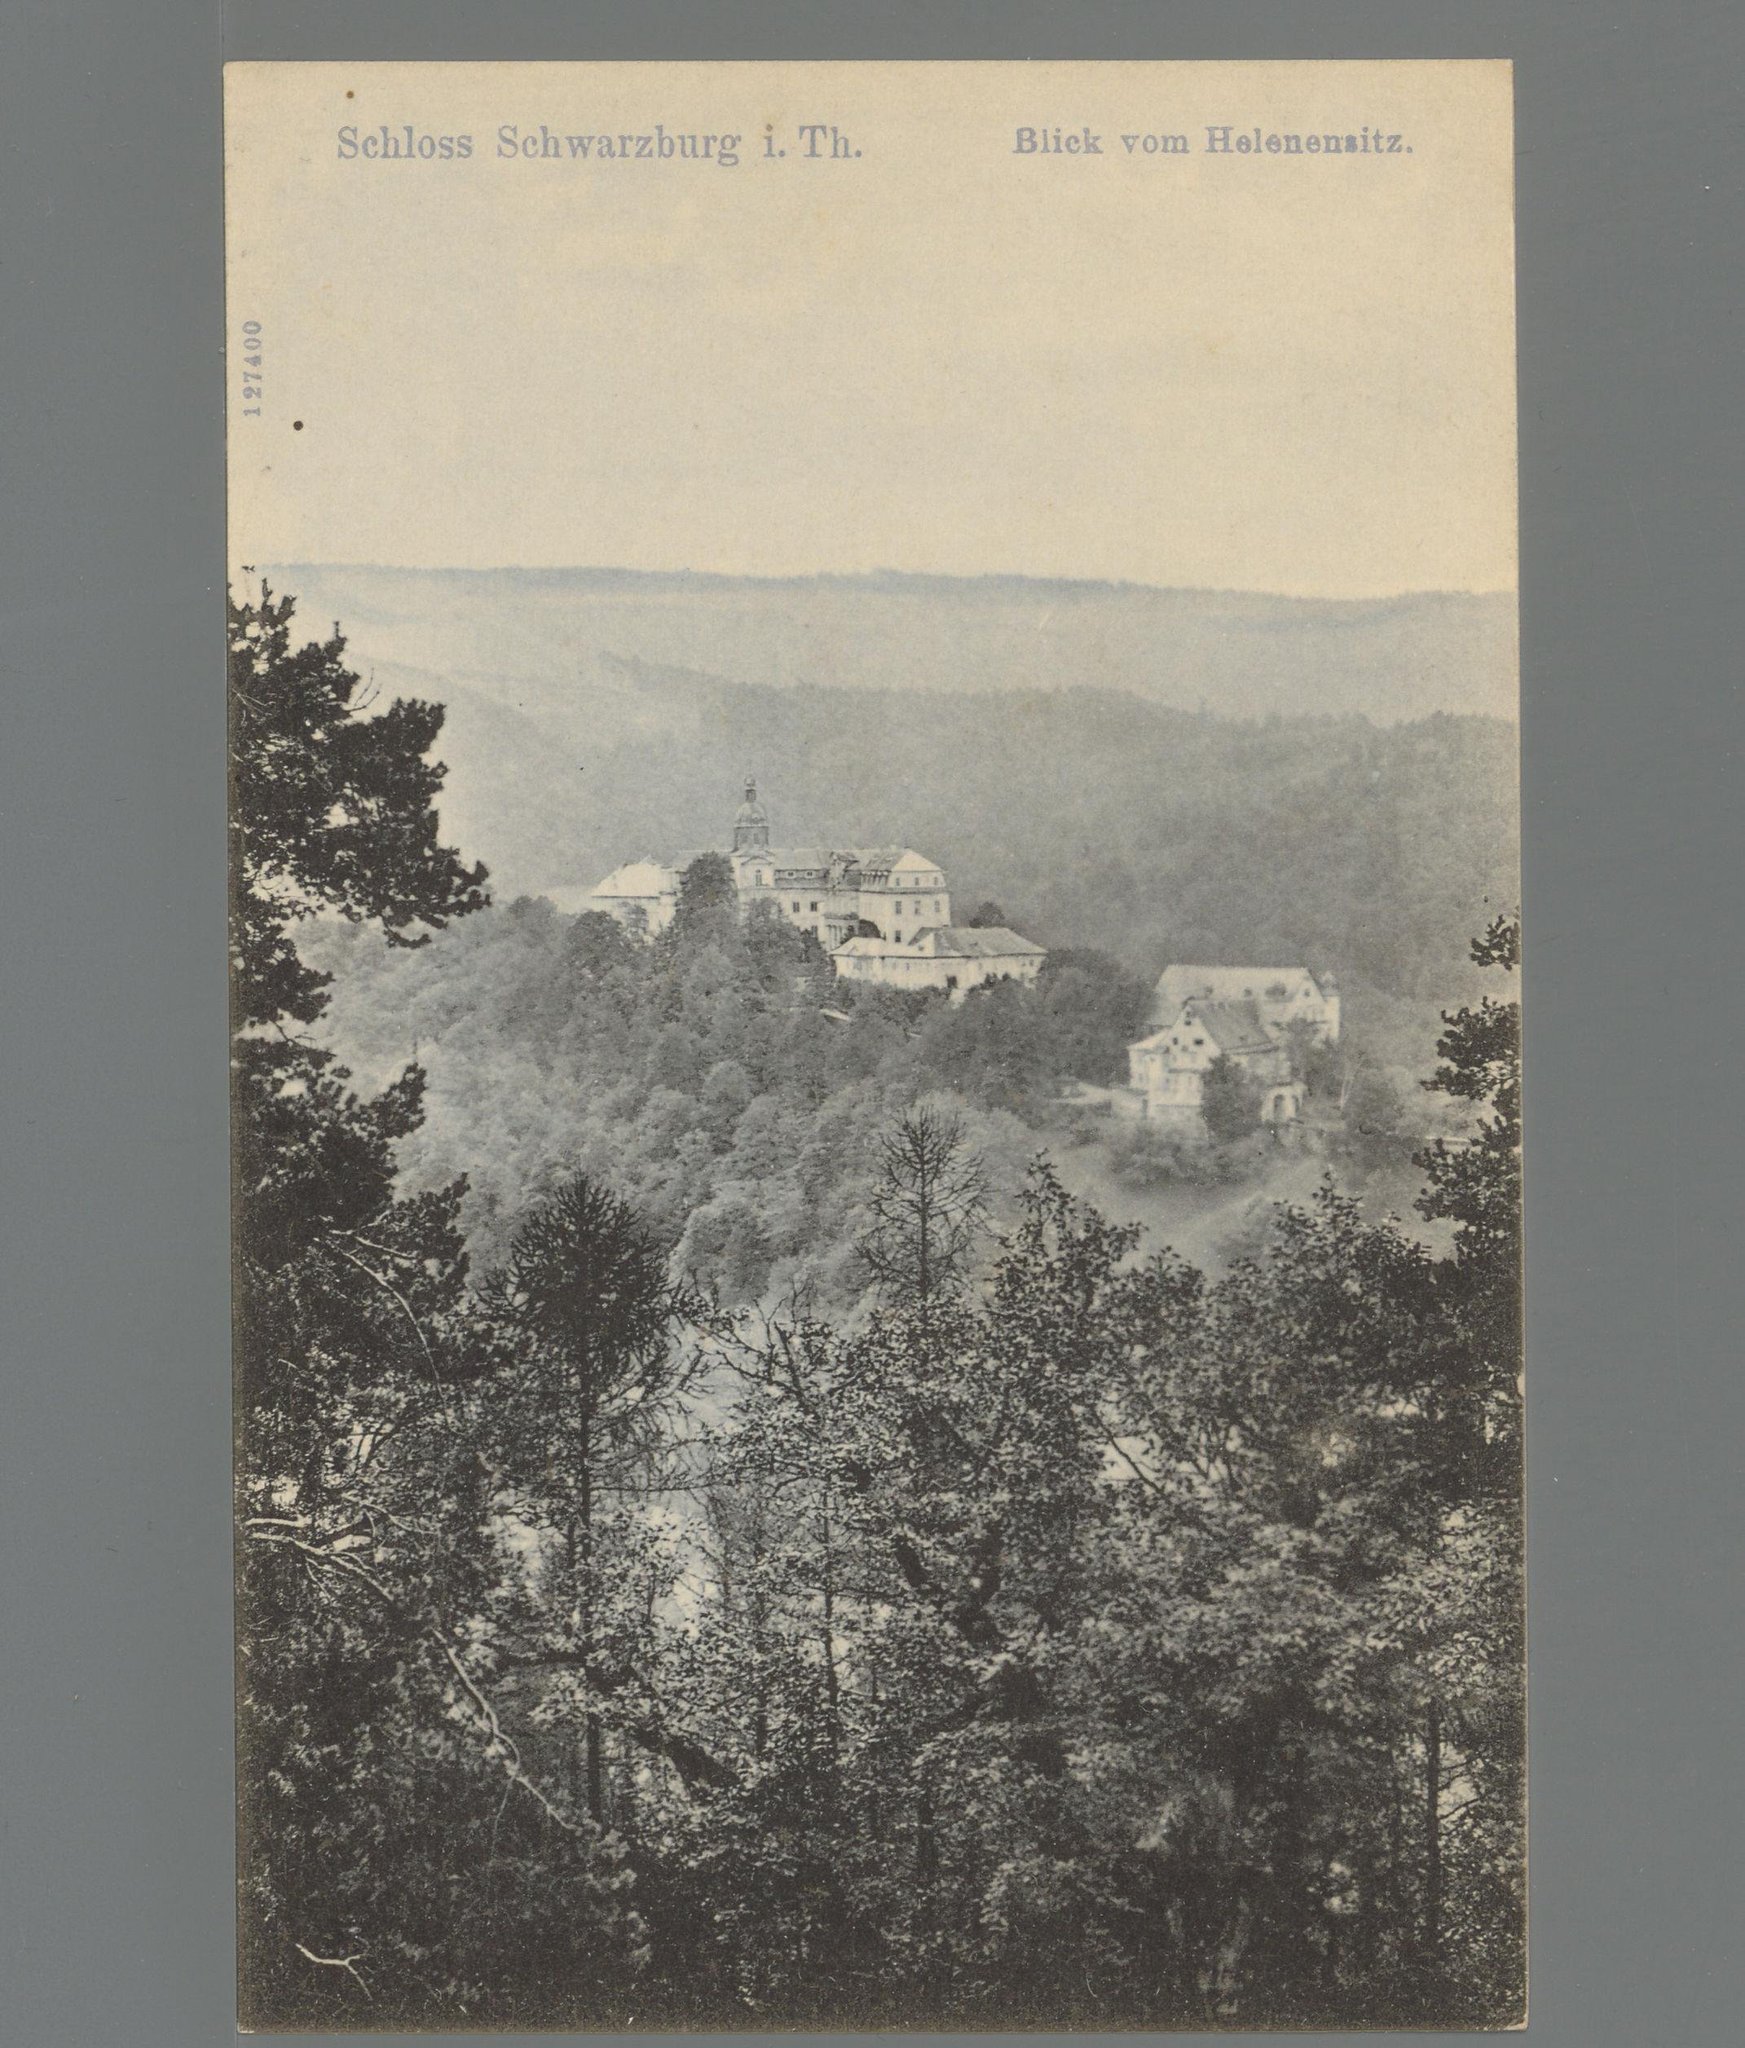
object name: ansichtkaart, prentbriefkaart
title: Schloss Schwarzburg i. Th. Blick vom Helenensitz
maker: Anonymous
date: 1905-1909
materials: cardboard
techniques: photograph, writing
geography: trier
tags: castle, mountains